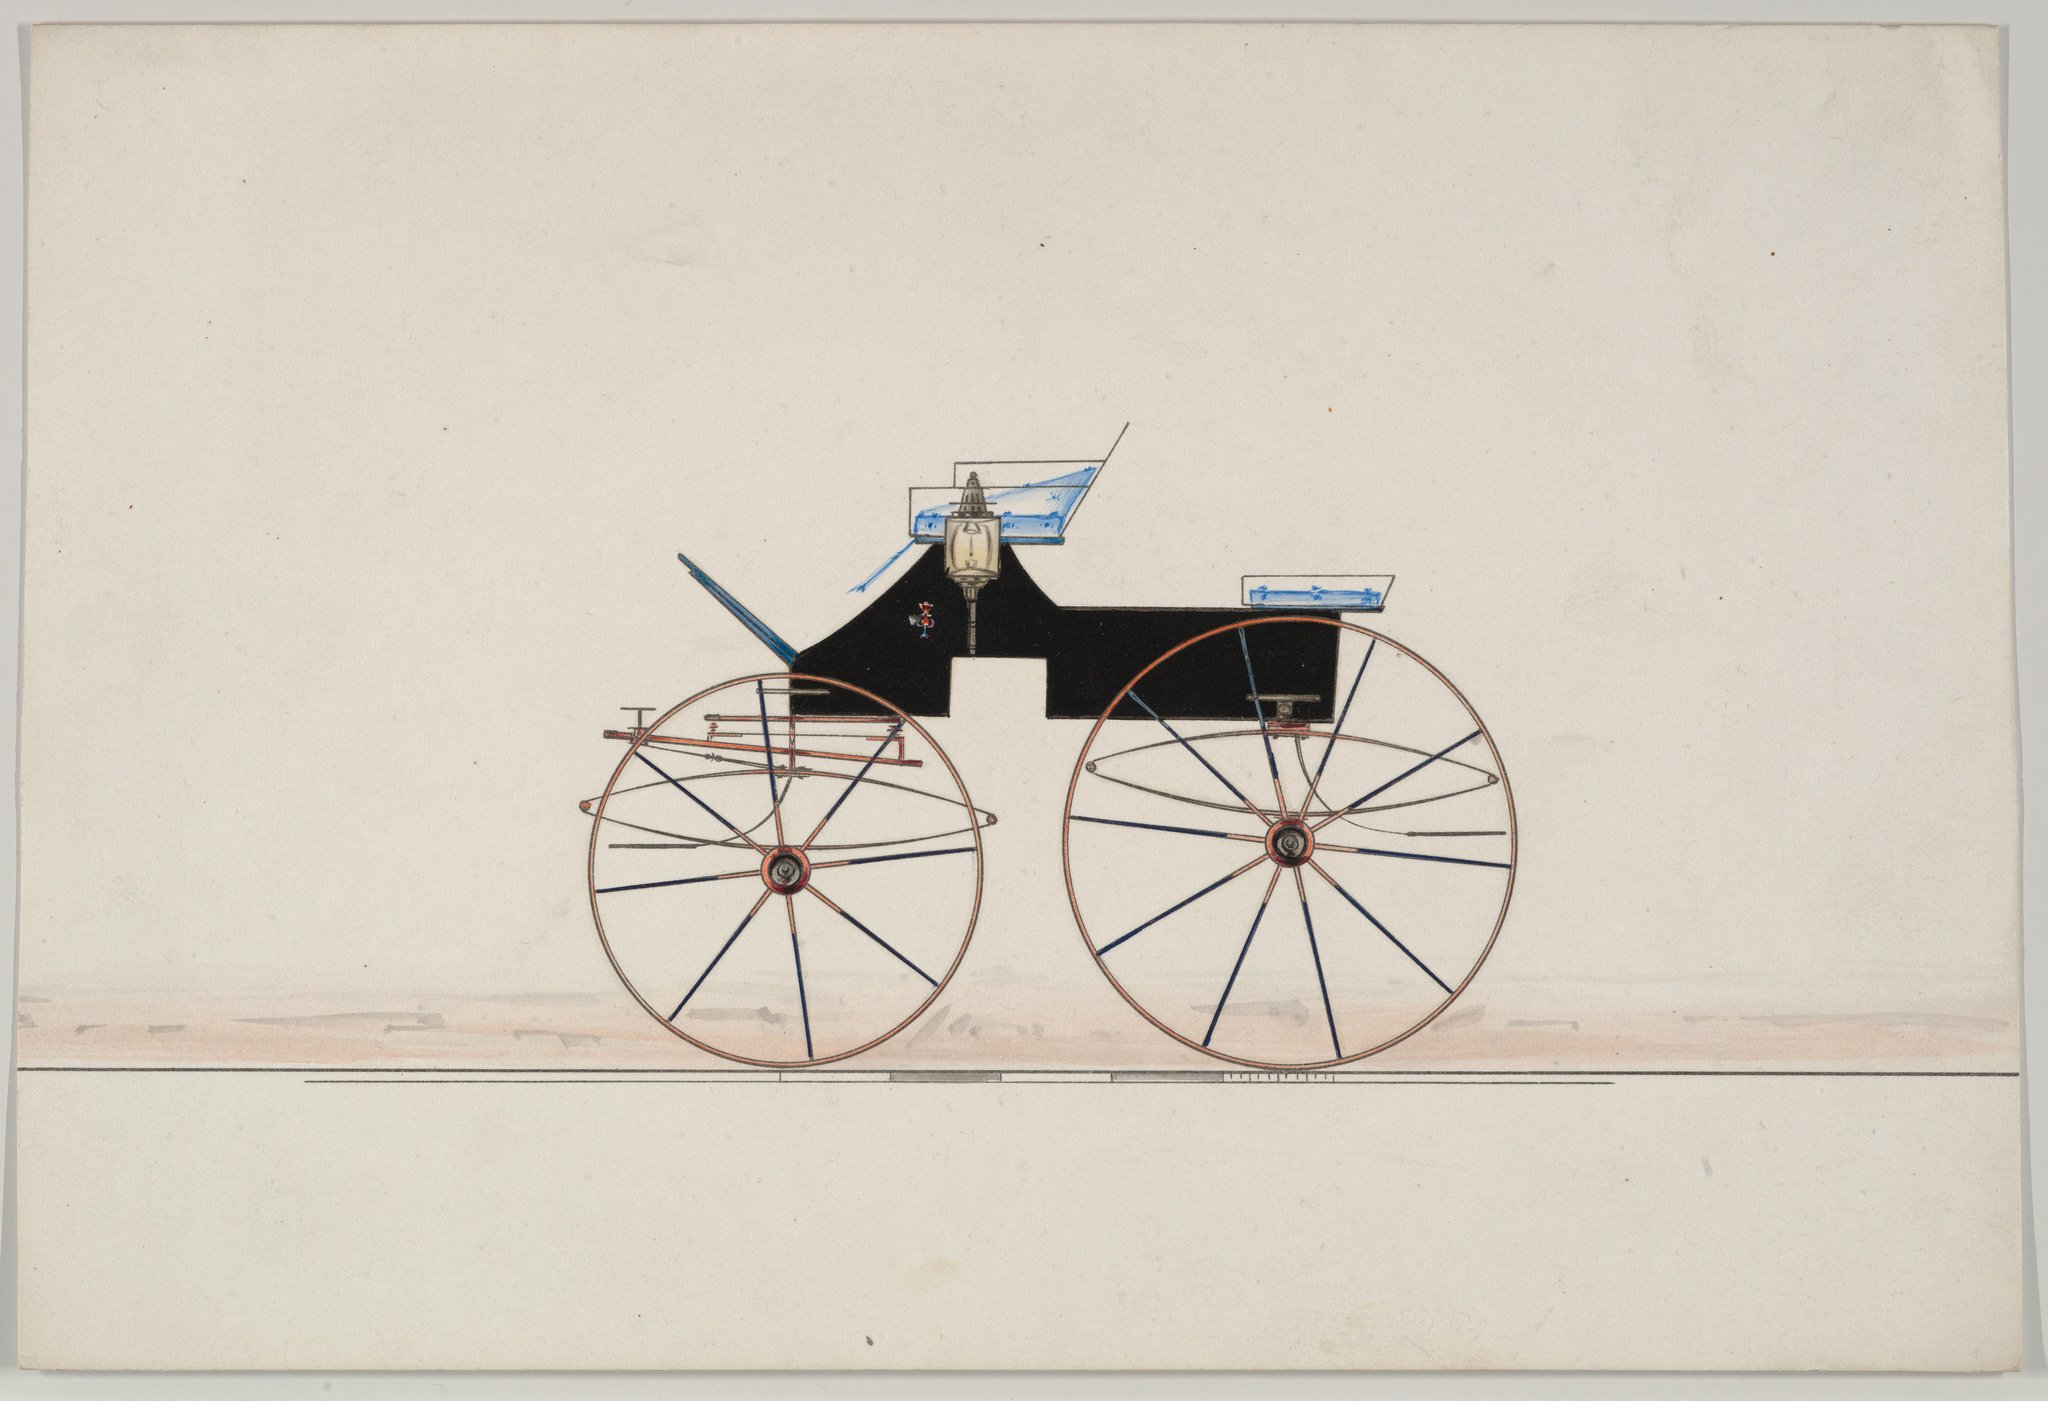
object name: drawing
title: Phaeton, no top (unnumbered)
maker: brewster & co.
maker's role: manufacturer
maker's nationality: american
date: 1850-1870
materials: gouache, gum arabic, ink, watercolor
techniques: pen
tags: carriages